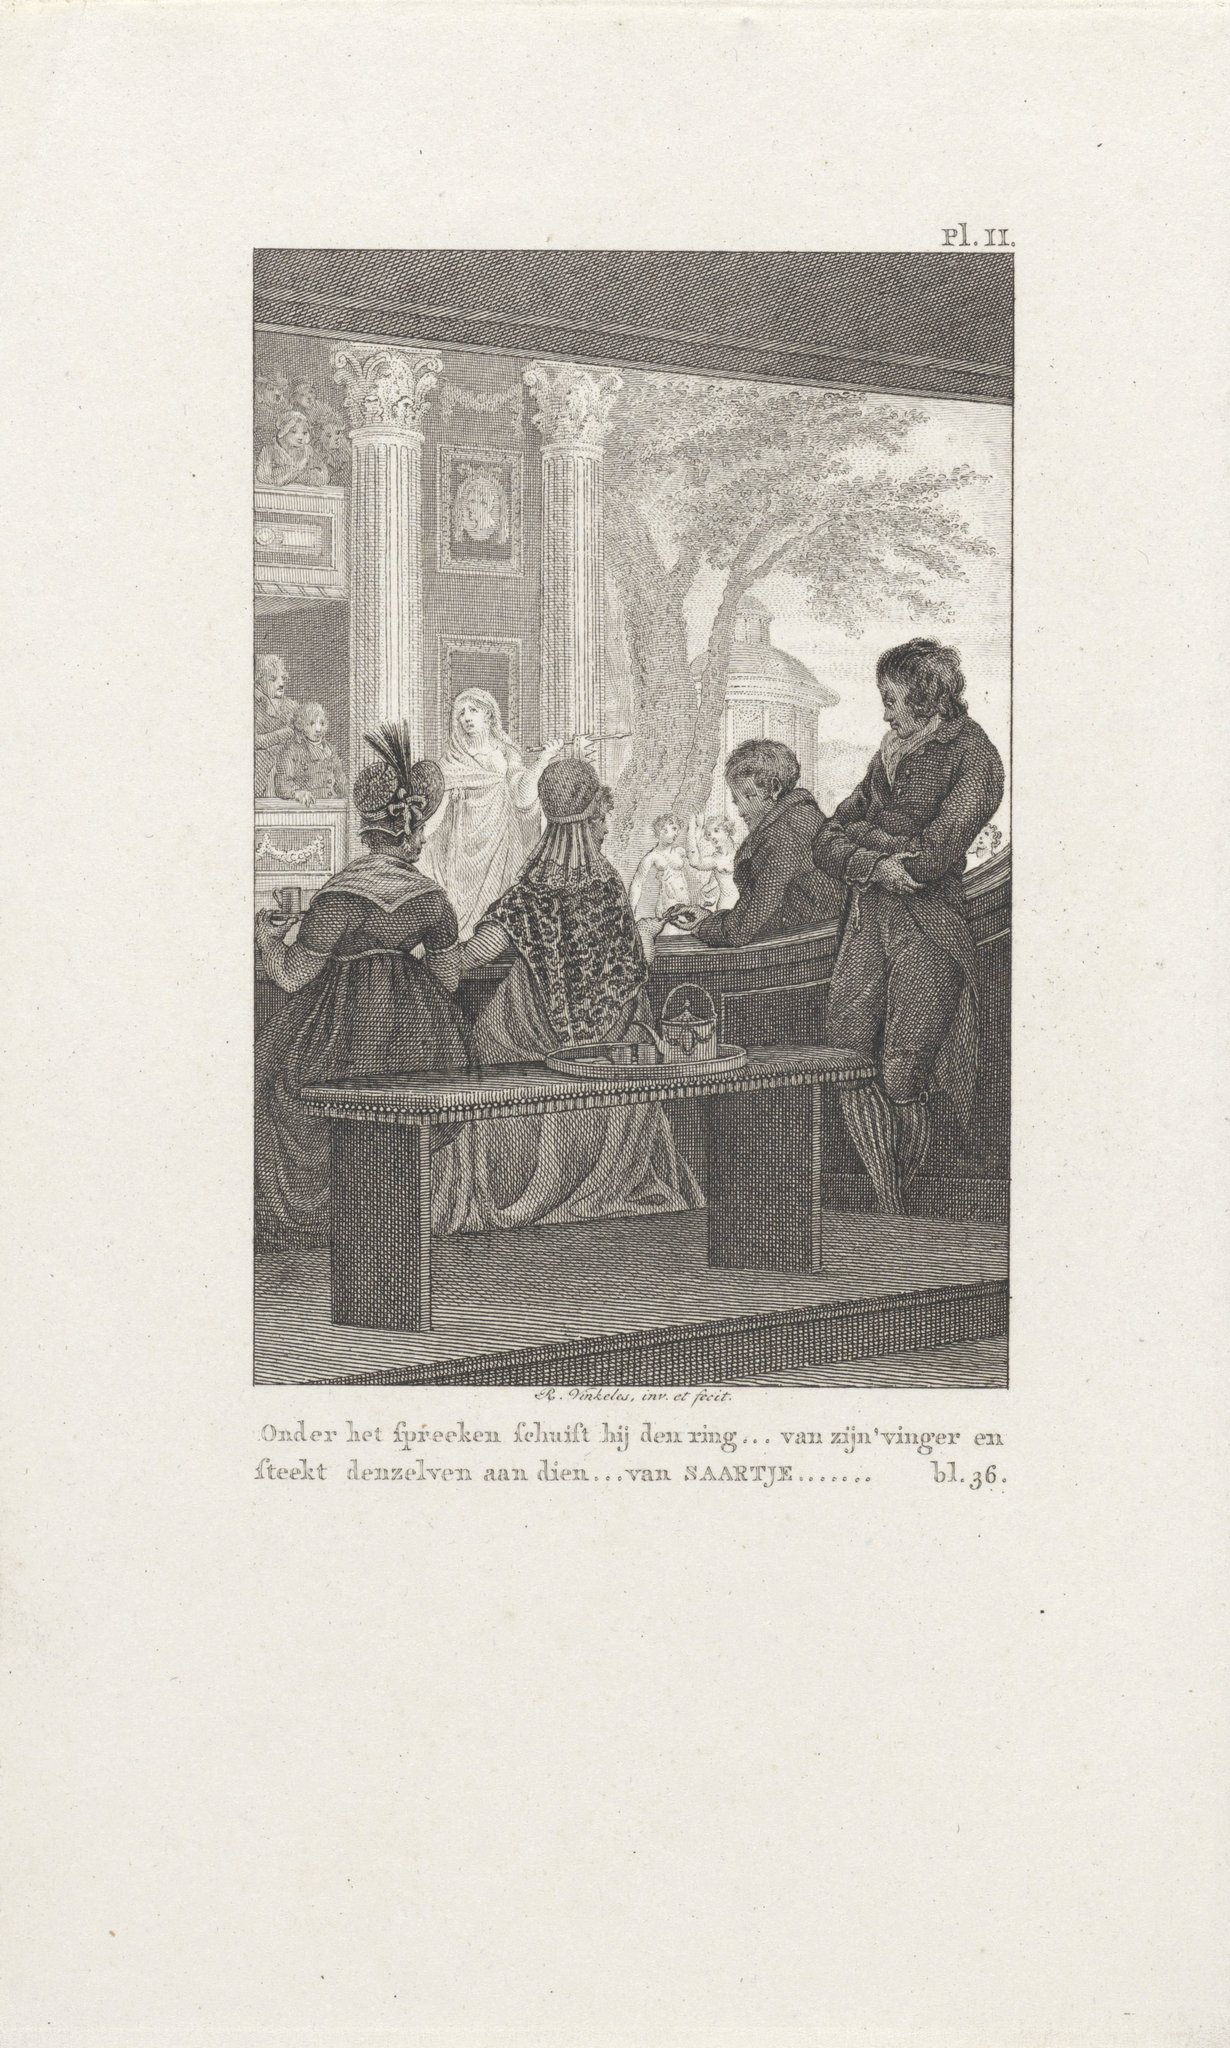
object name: print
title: Saartje en Cornelis in een theater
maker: reinier vinkeles (i)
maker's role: draughtsman, print maker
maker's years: 1741-1816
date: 1804-1805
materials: paper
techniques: engraving, etching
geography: amsterdam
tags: theatre, theatrical performance, theatre (building), ring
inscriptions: collector's mark: Lugt 2228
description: Terwijl enkele figuren naar een toneelstuk in de schouwburg kijken, schuift een man een ring om de vinger van Saartje. Cornelis slaat het tafereel met grote ontevredenheid gade. Illustratie bij het verhaal Sara Houttuin.